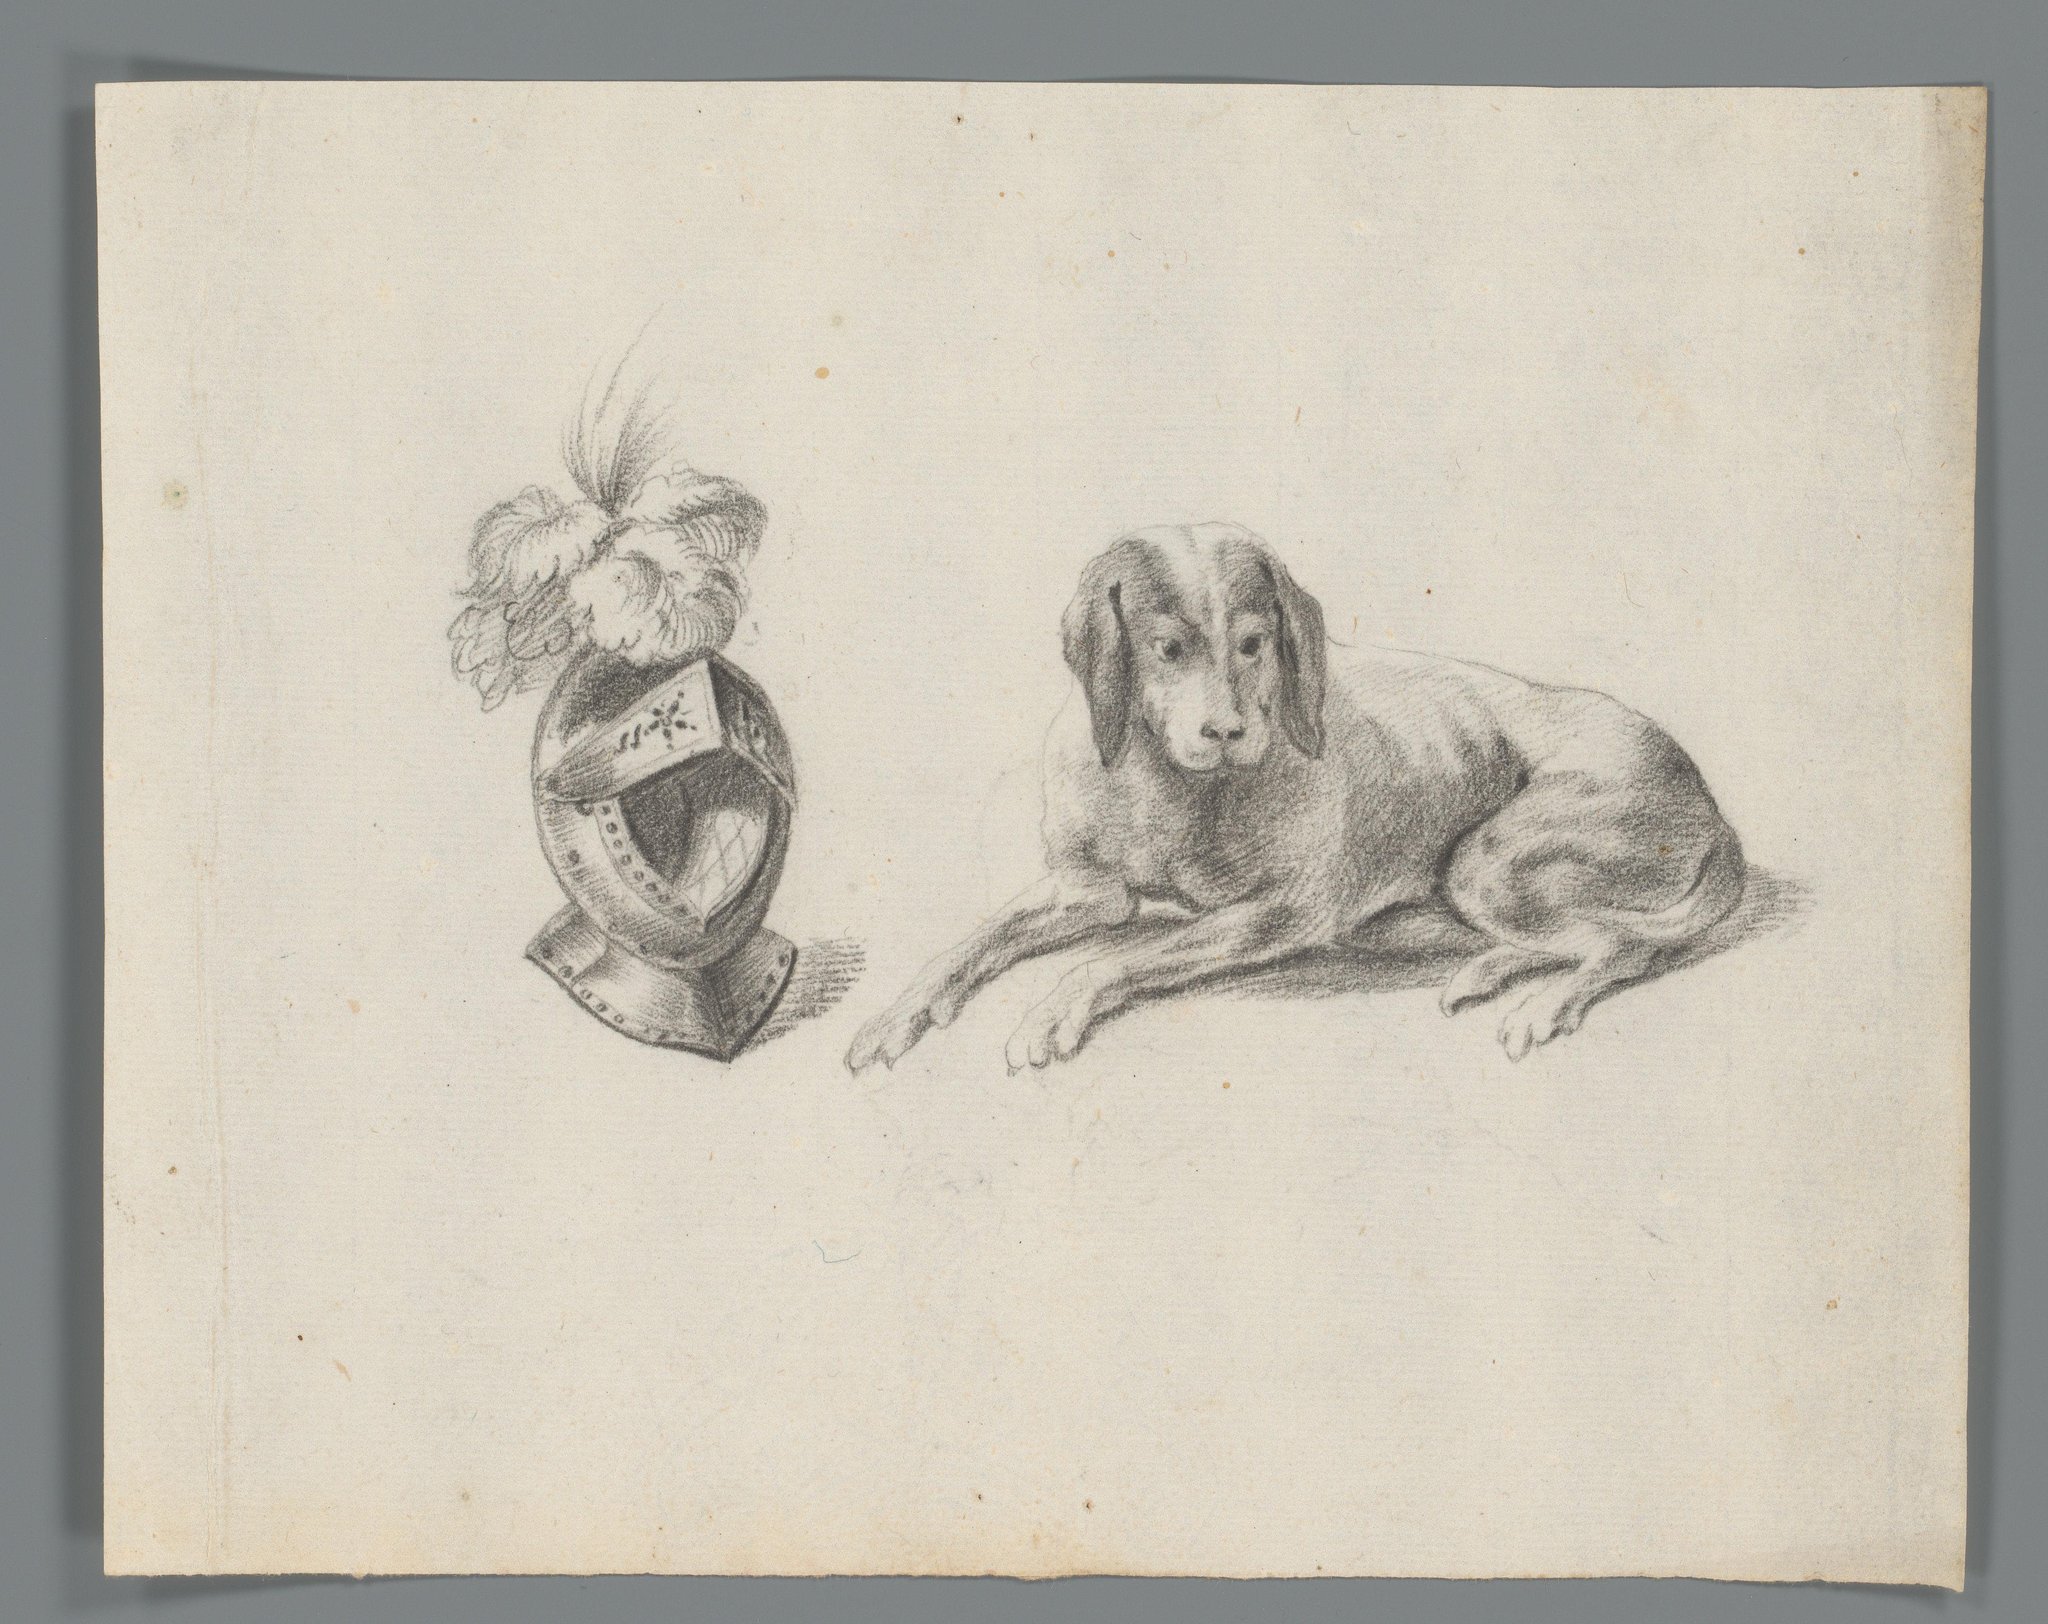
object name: drawing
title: Helm met veren en liggende hond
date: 1700-1799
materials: chalk, paper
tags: helmet, dog